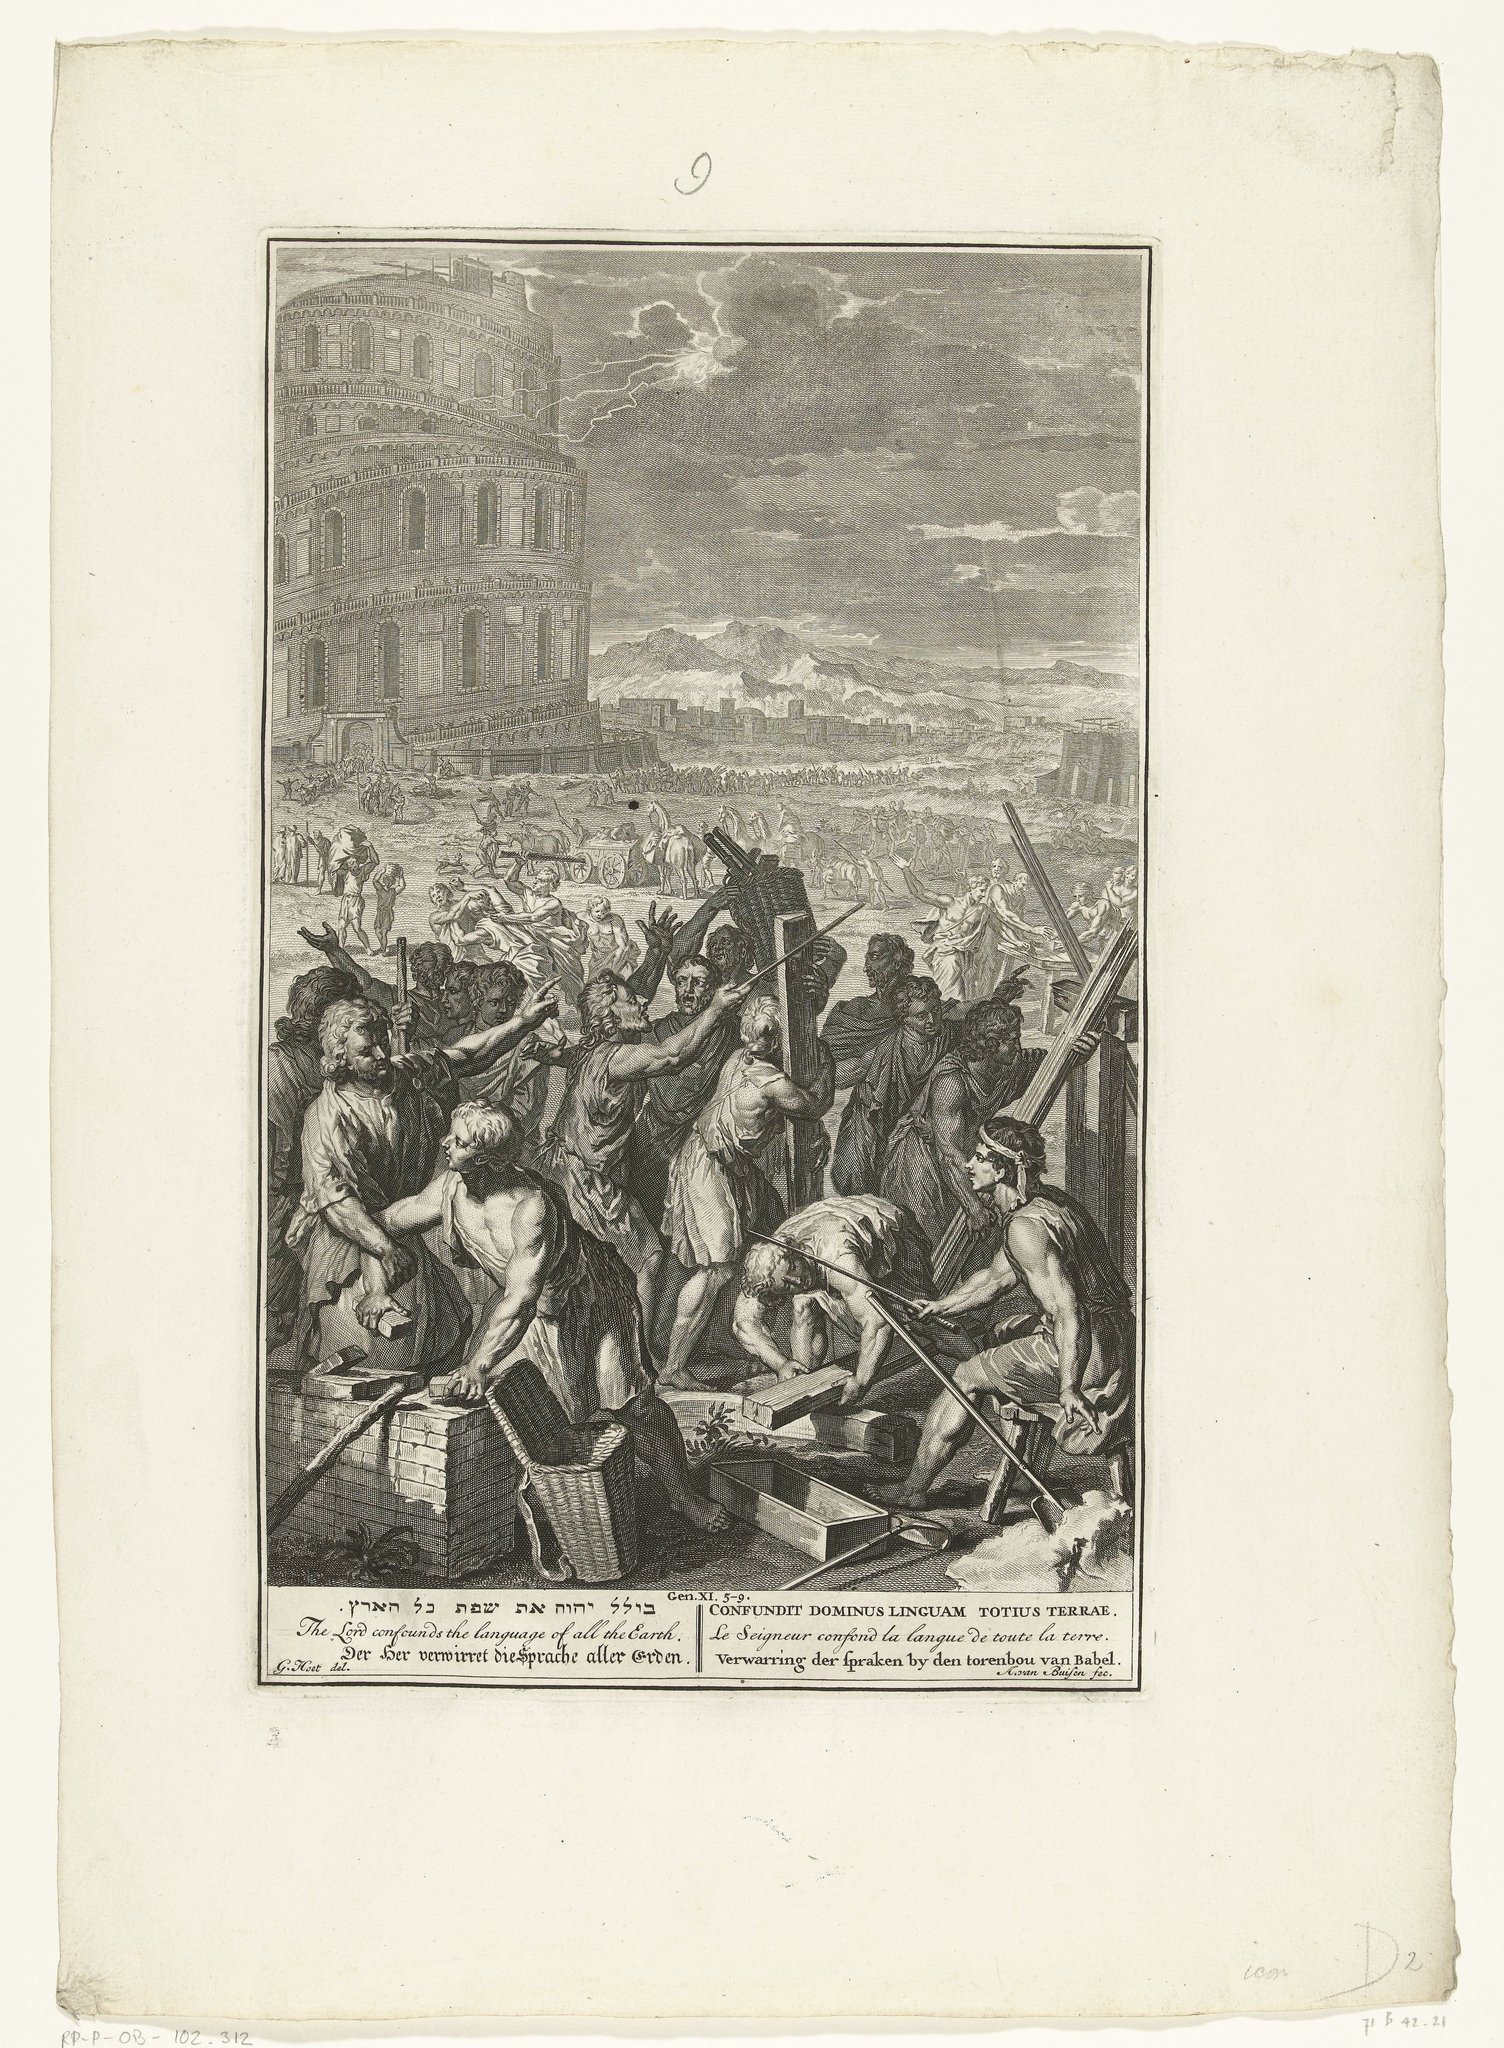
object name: book illustration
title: Verwarring der spraken by den torenbou van Babel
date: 1711-1720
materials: paper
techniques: engraving, etching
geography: amsterdam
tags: the confusion of languages and the scattering of people over the earth ~ story of the tower of babel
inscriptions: collector's mark: Lugt 2228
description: De bouw van de toren te Babel. De mensen die aan de toren werken kunnen elkaars taal niet verstaan, dit bemoeilijkt het werk aan dit enorme bouwwerk. Illustratie voor het Oude Testament, Gen. 11, 5-9. Onder de voorstelling een titel in het Hebreeuws, Engels, Duits, Latijn, Frans en Nederlands.